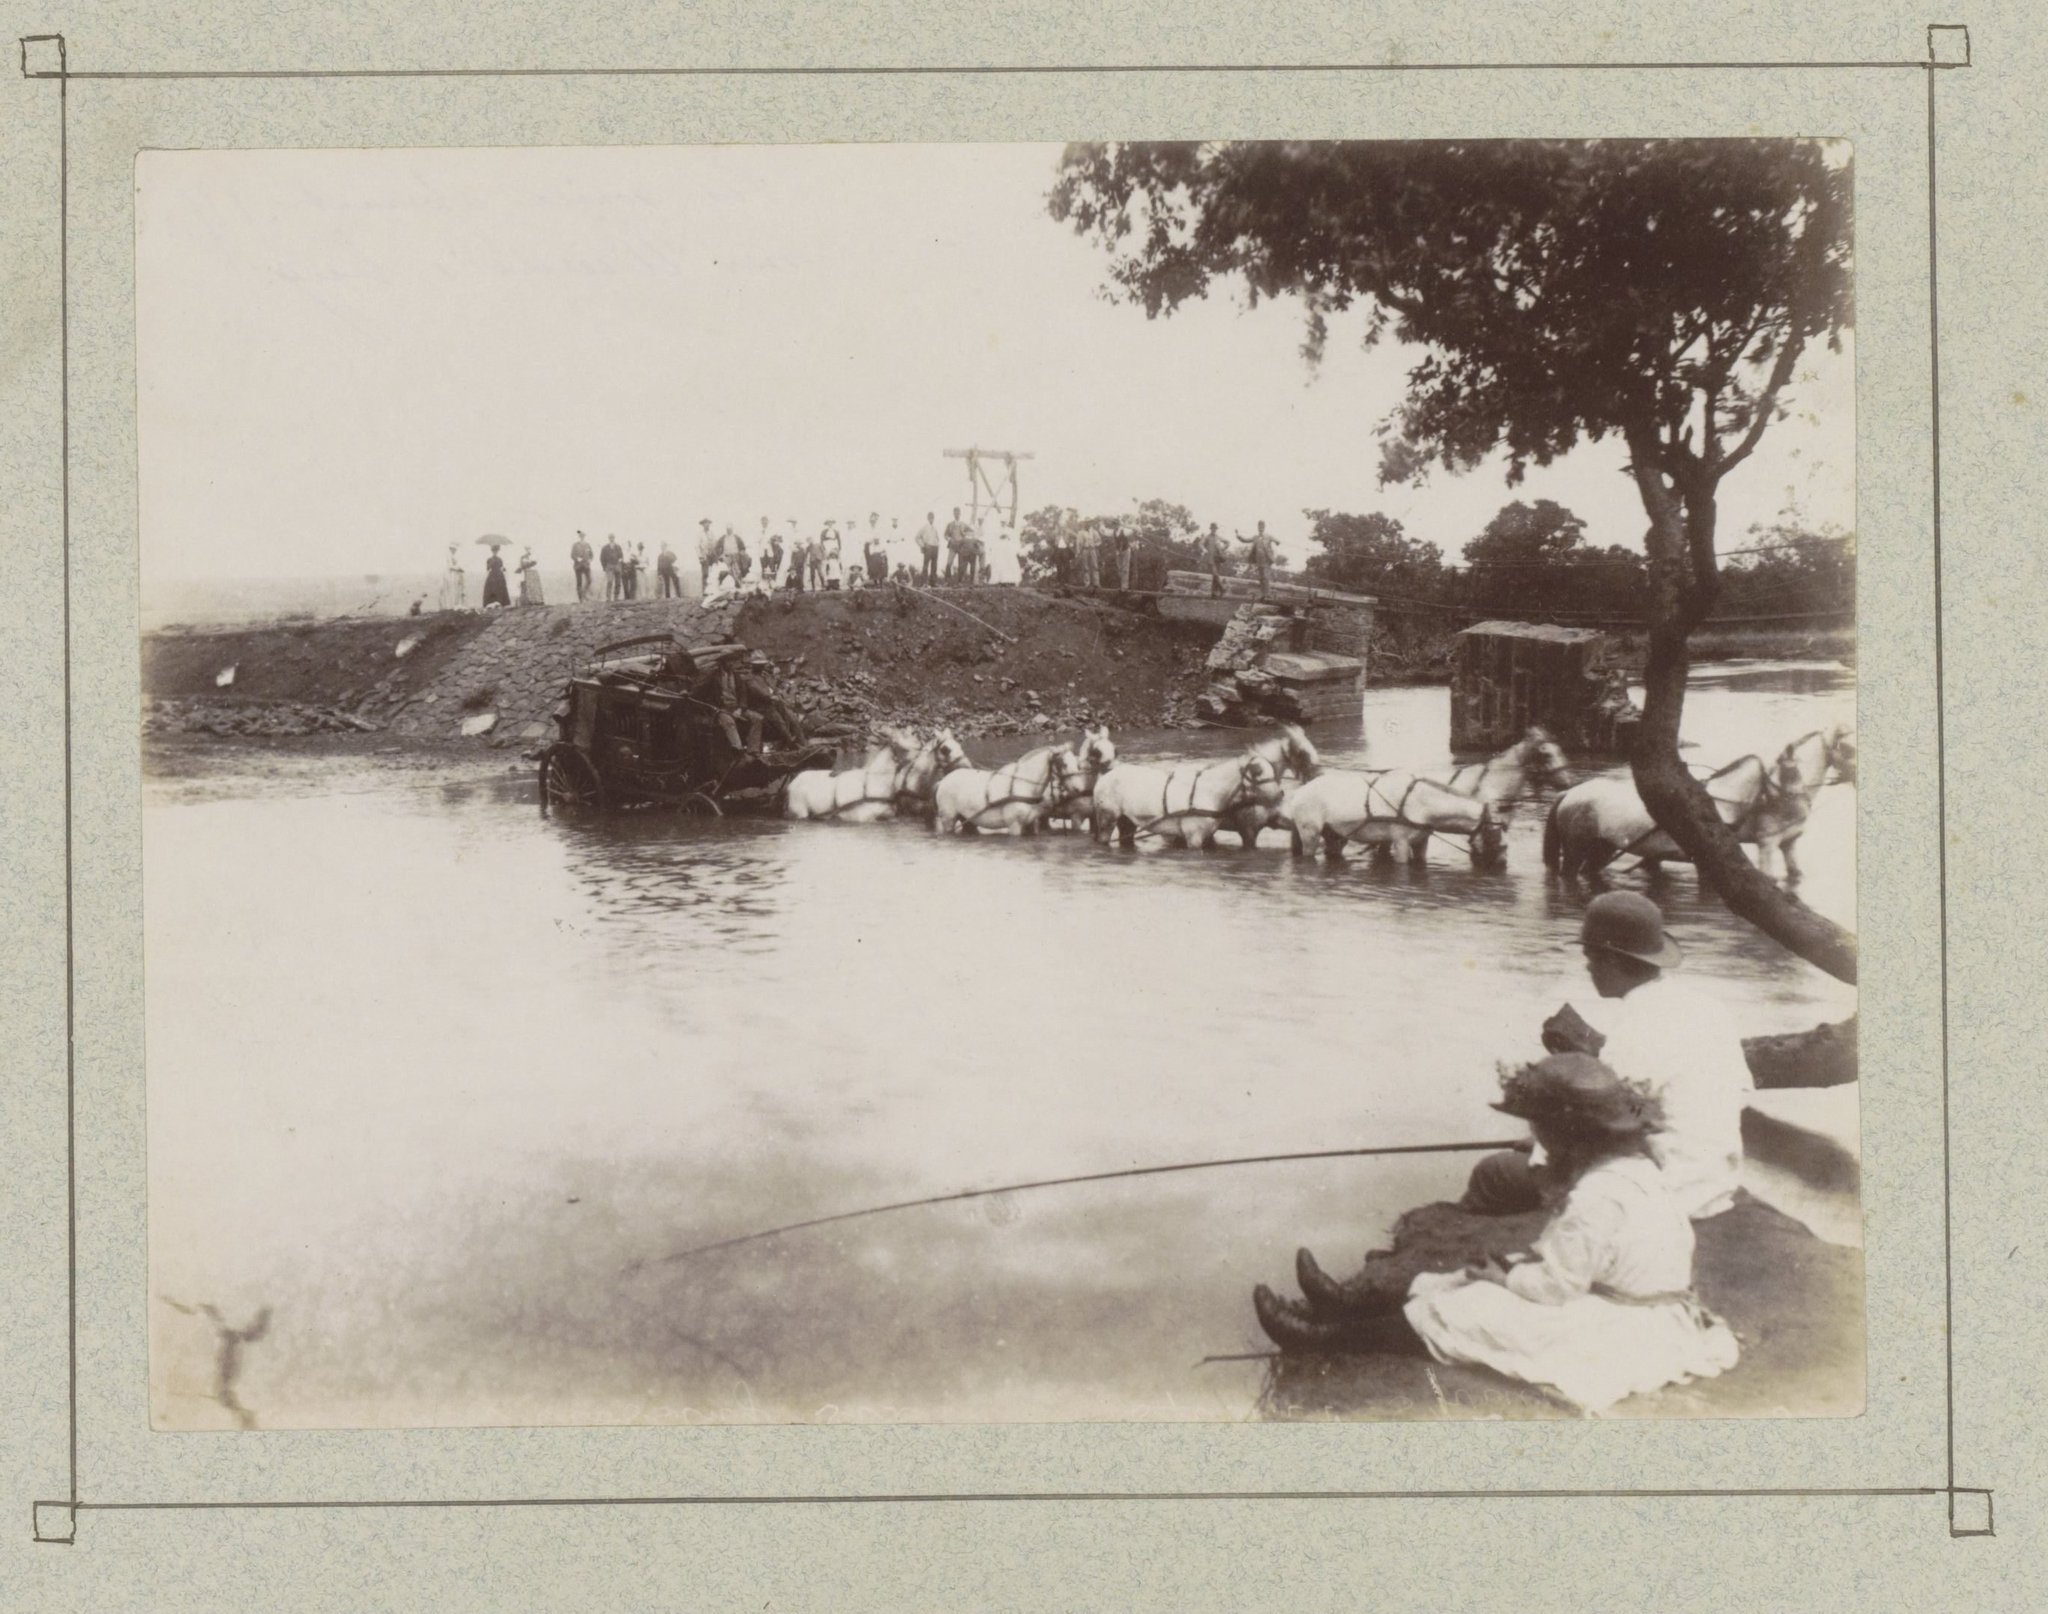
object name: photograph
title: Door paarden getrokken koets doorkruist water in Zuid-Afrika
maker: Anonymous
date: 1880-1900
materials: photographic support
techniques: albumen print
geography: south africa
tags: diligence, omnibus, horse-tram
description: Onderdeel van Reisalbum met foto's van Zuid-Afrika, Madeira, Portugal, Frankrijk en Duitsland.